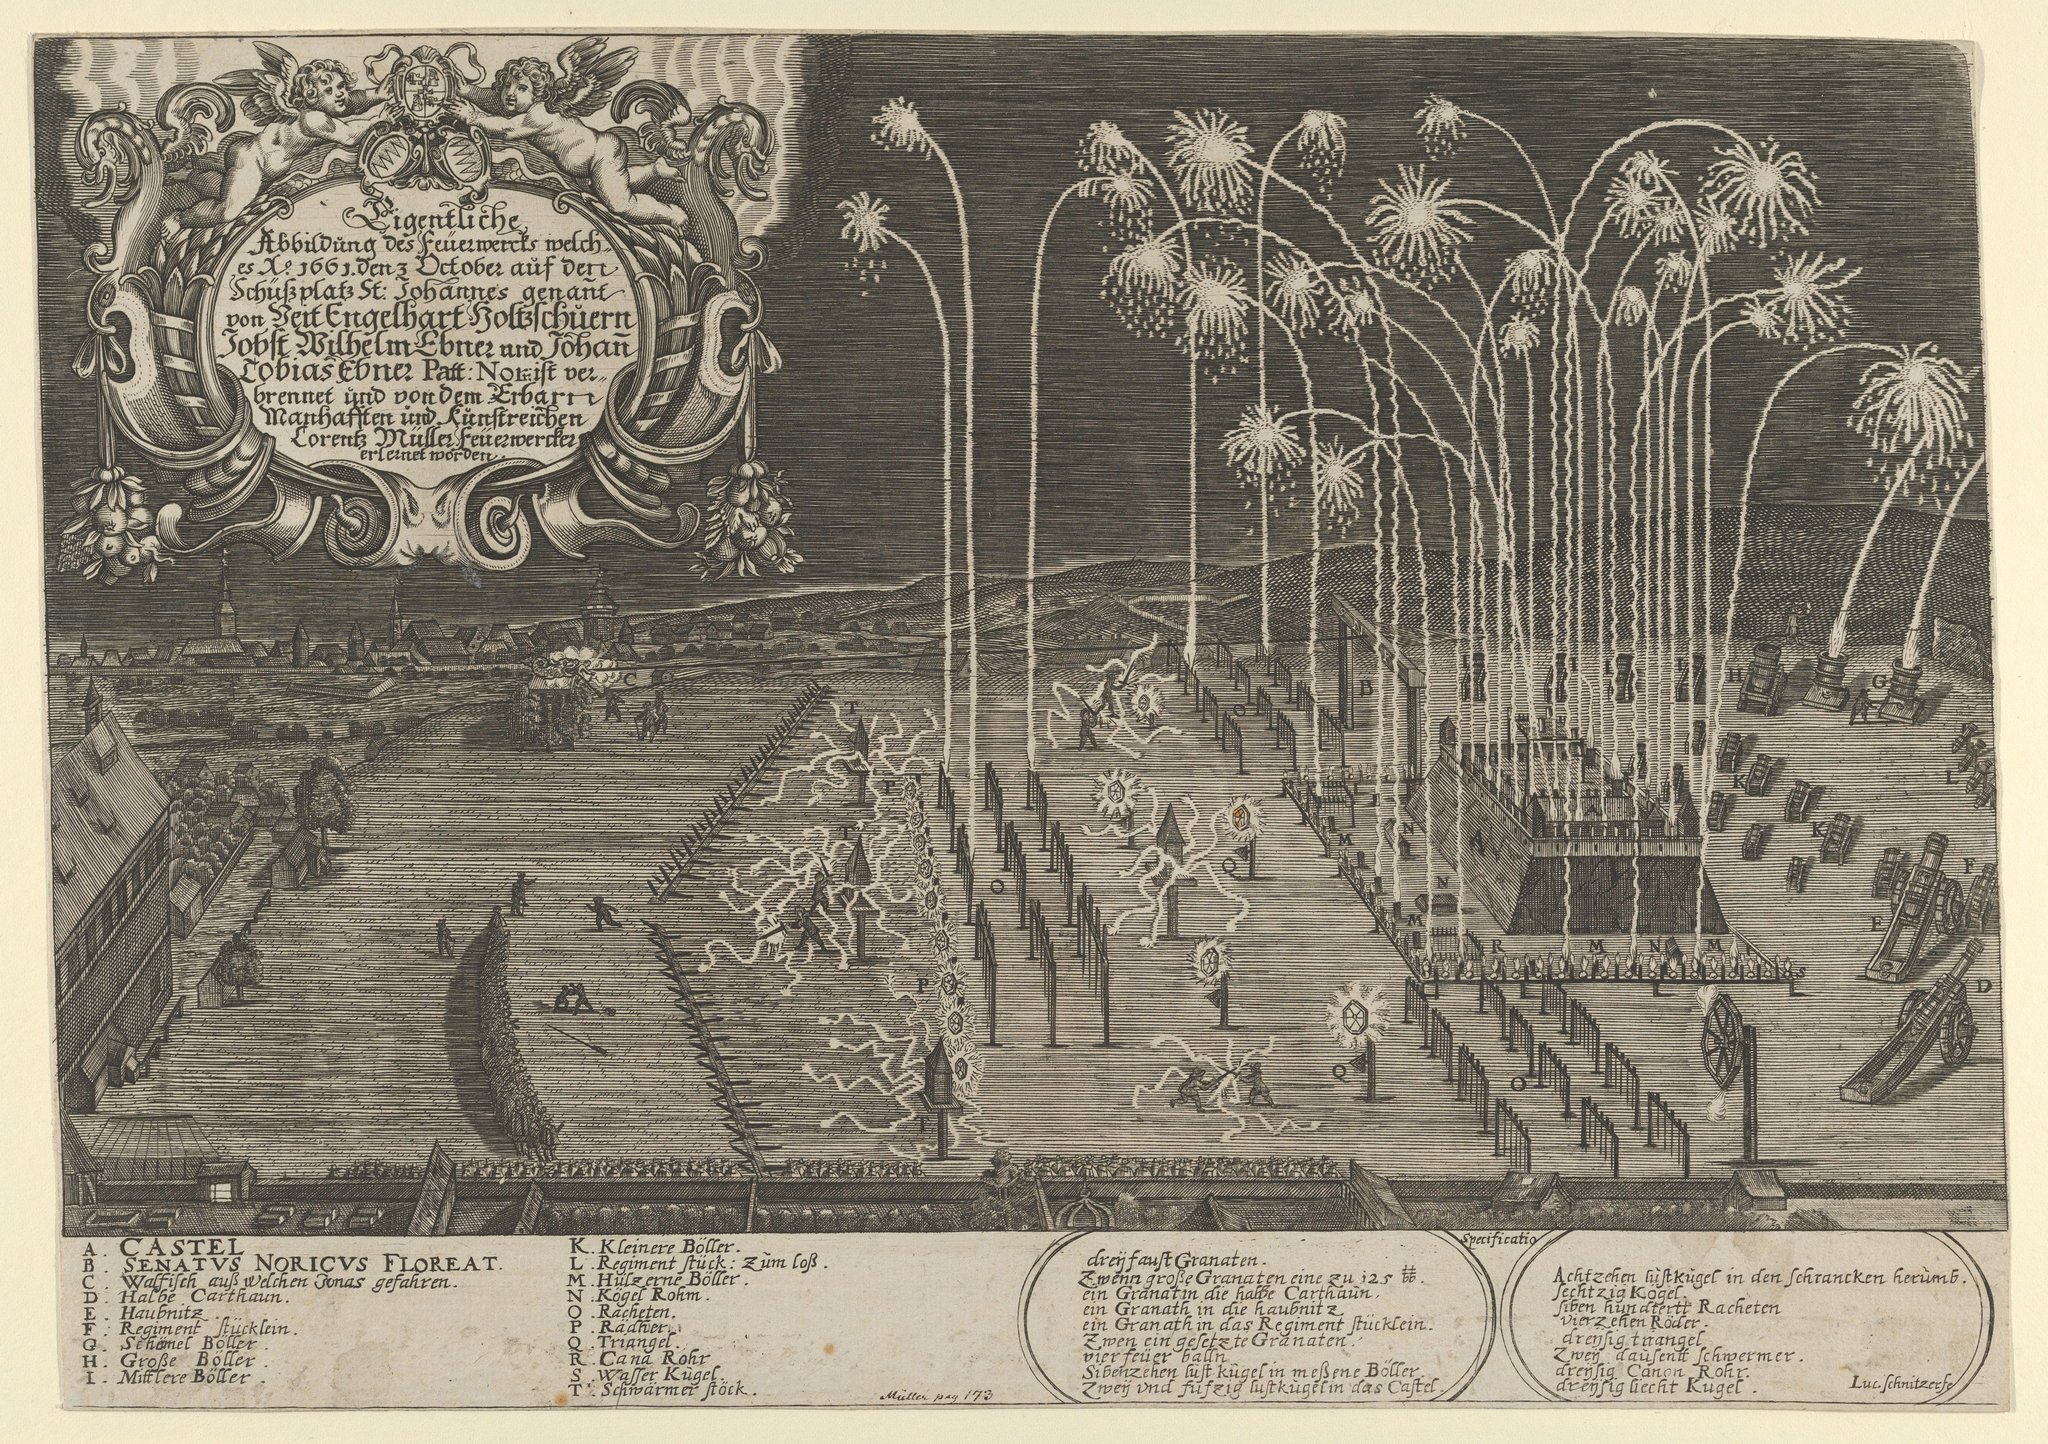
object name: print, fete, ornament architecture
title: Fireworks display by Engelhart Holtzschuer, Jobst Wilhelm Ebner and Johann Tobias Ebner as proof of mastership, Nuremberg, 1661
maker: lukas schnitzer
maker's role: artist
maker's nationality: german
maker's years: 1628-1676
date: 1661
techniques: etching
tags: human figures,cannons,cartouches,fireworks